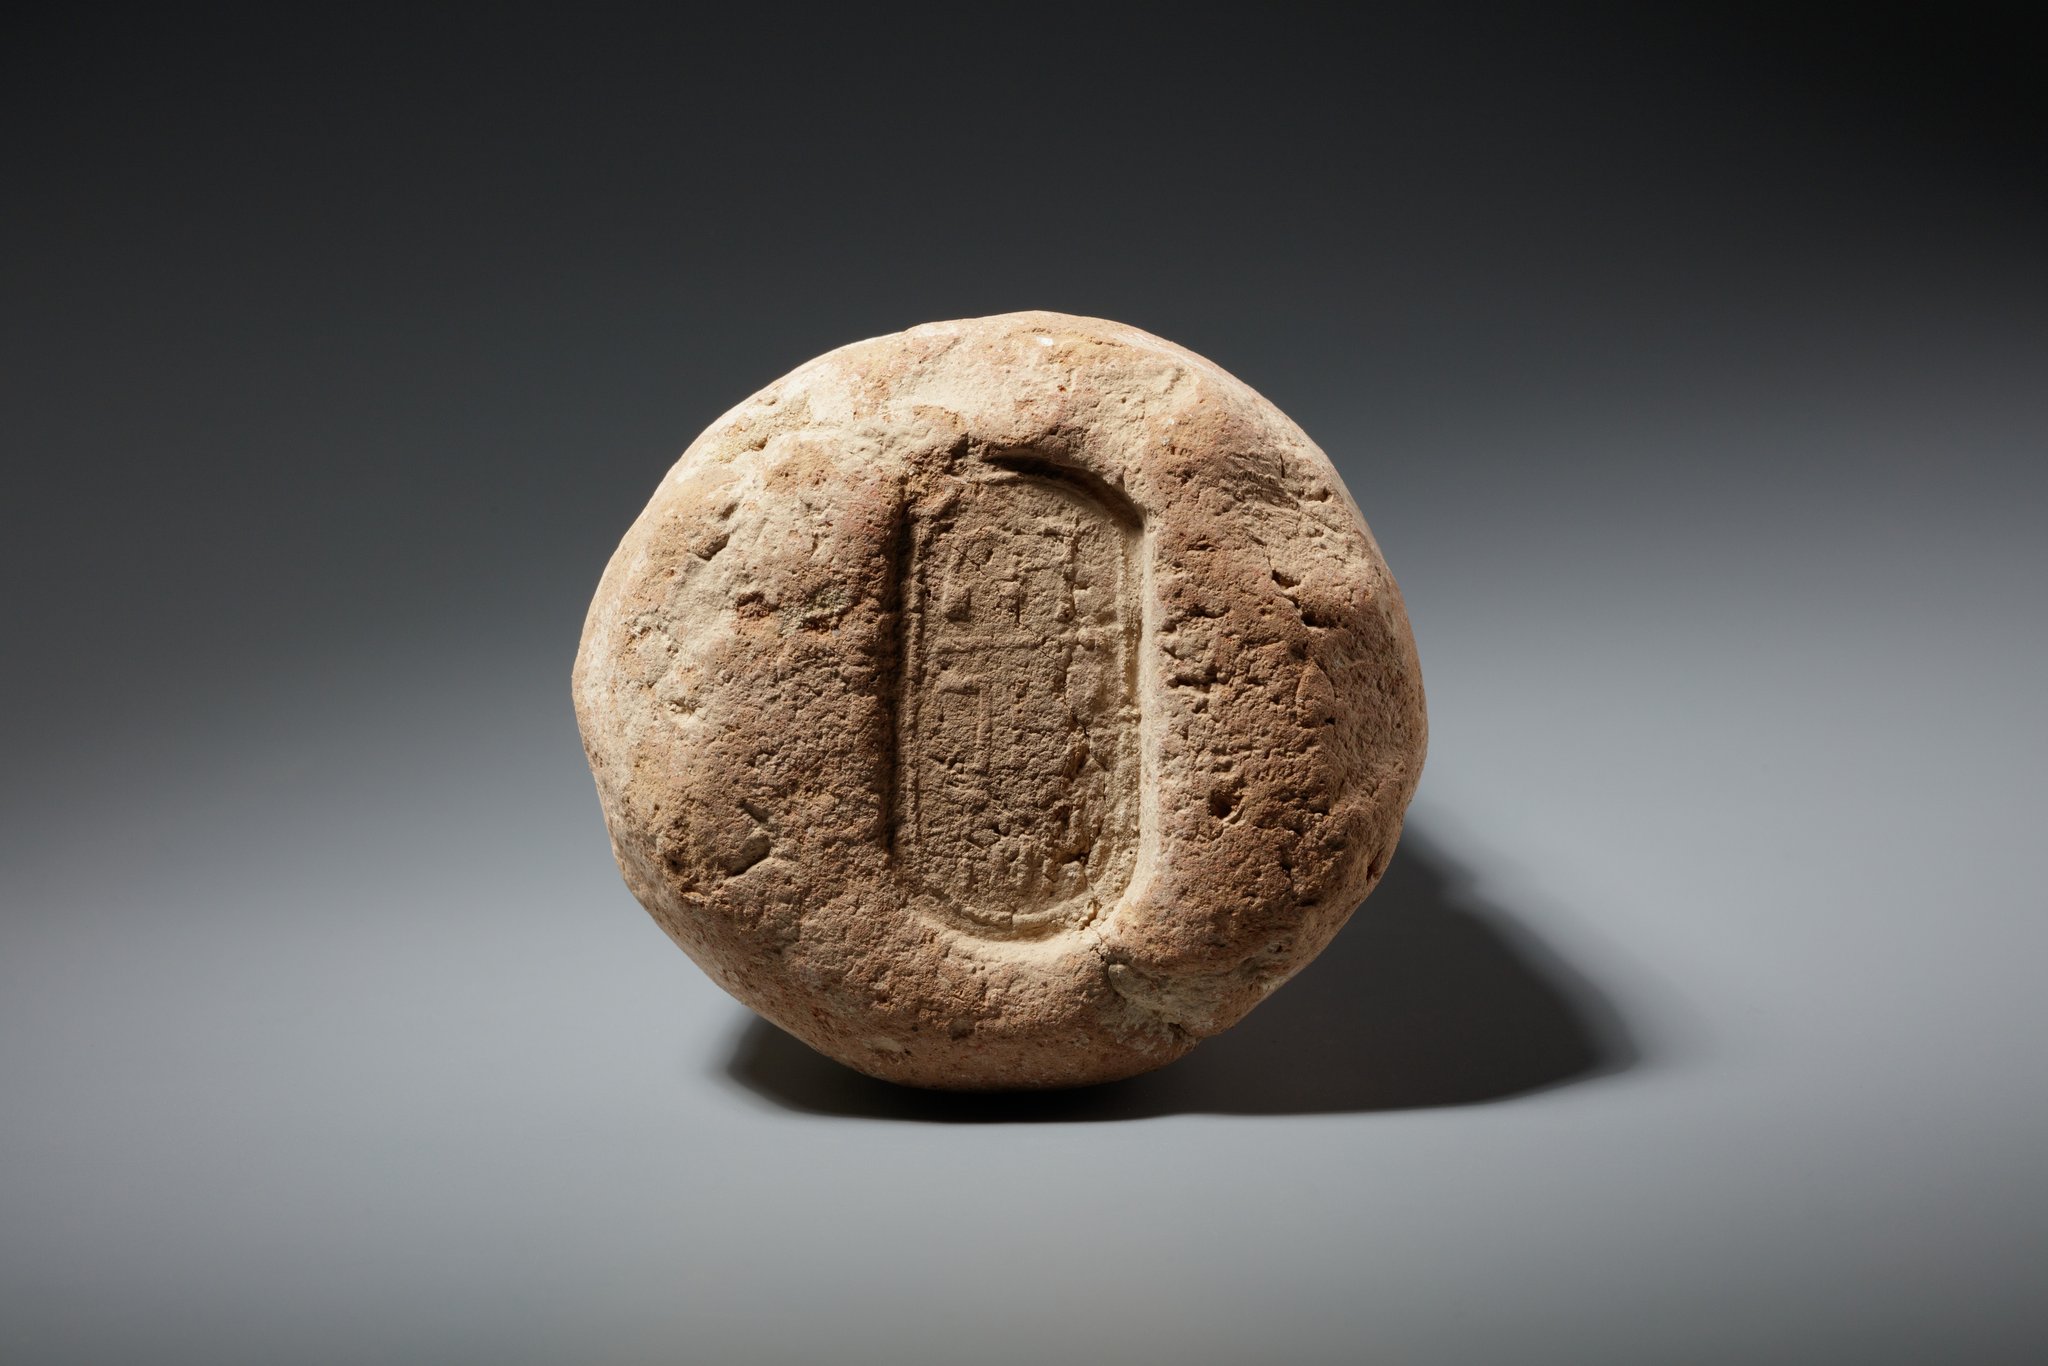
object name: cone, davy 348, wadjmose, scribe, second prophet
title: Funerary Cone of the Scribe Wadjmose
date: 1550-1295 BCE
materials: pottery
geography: egypt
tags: hieroglyphs